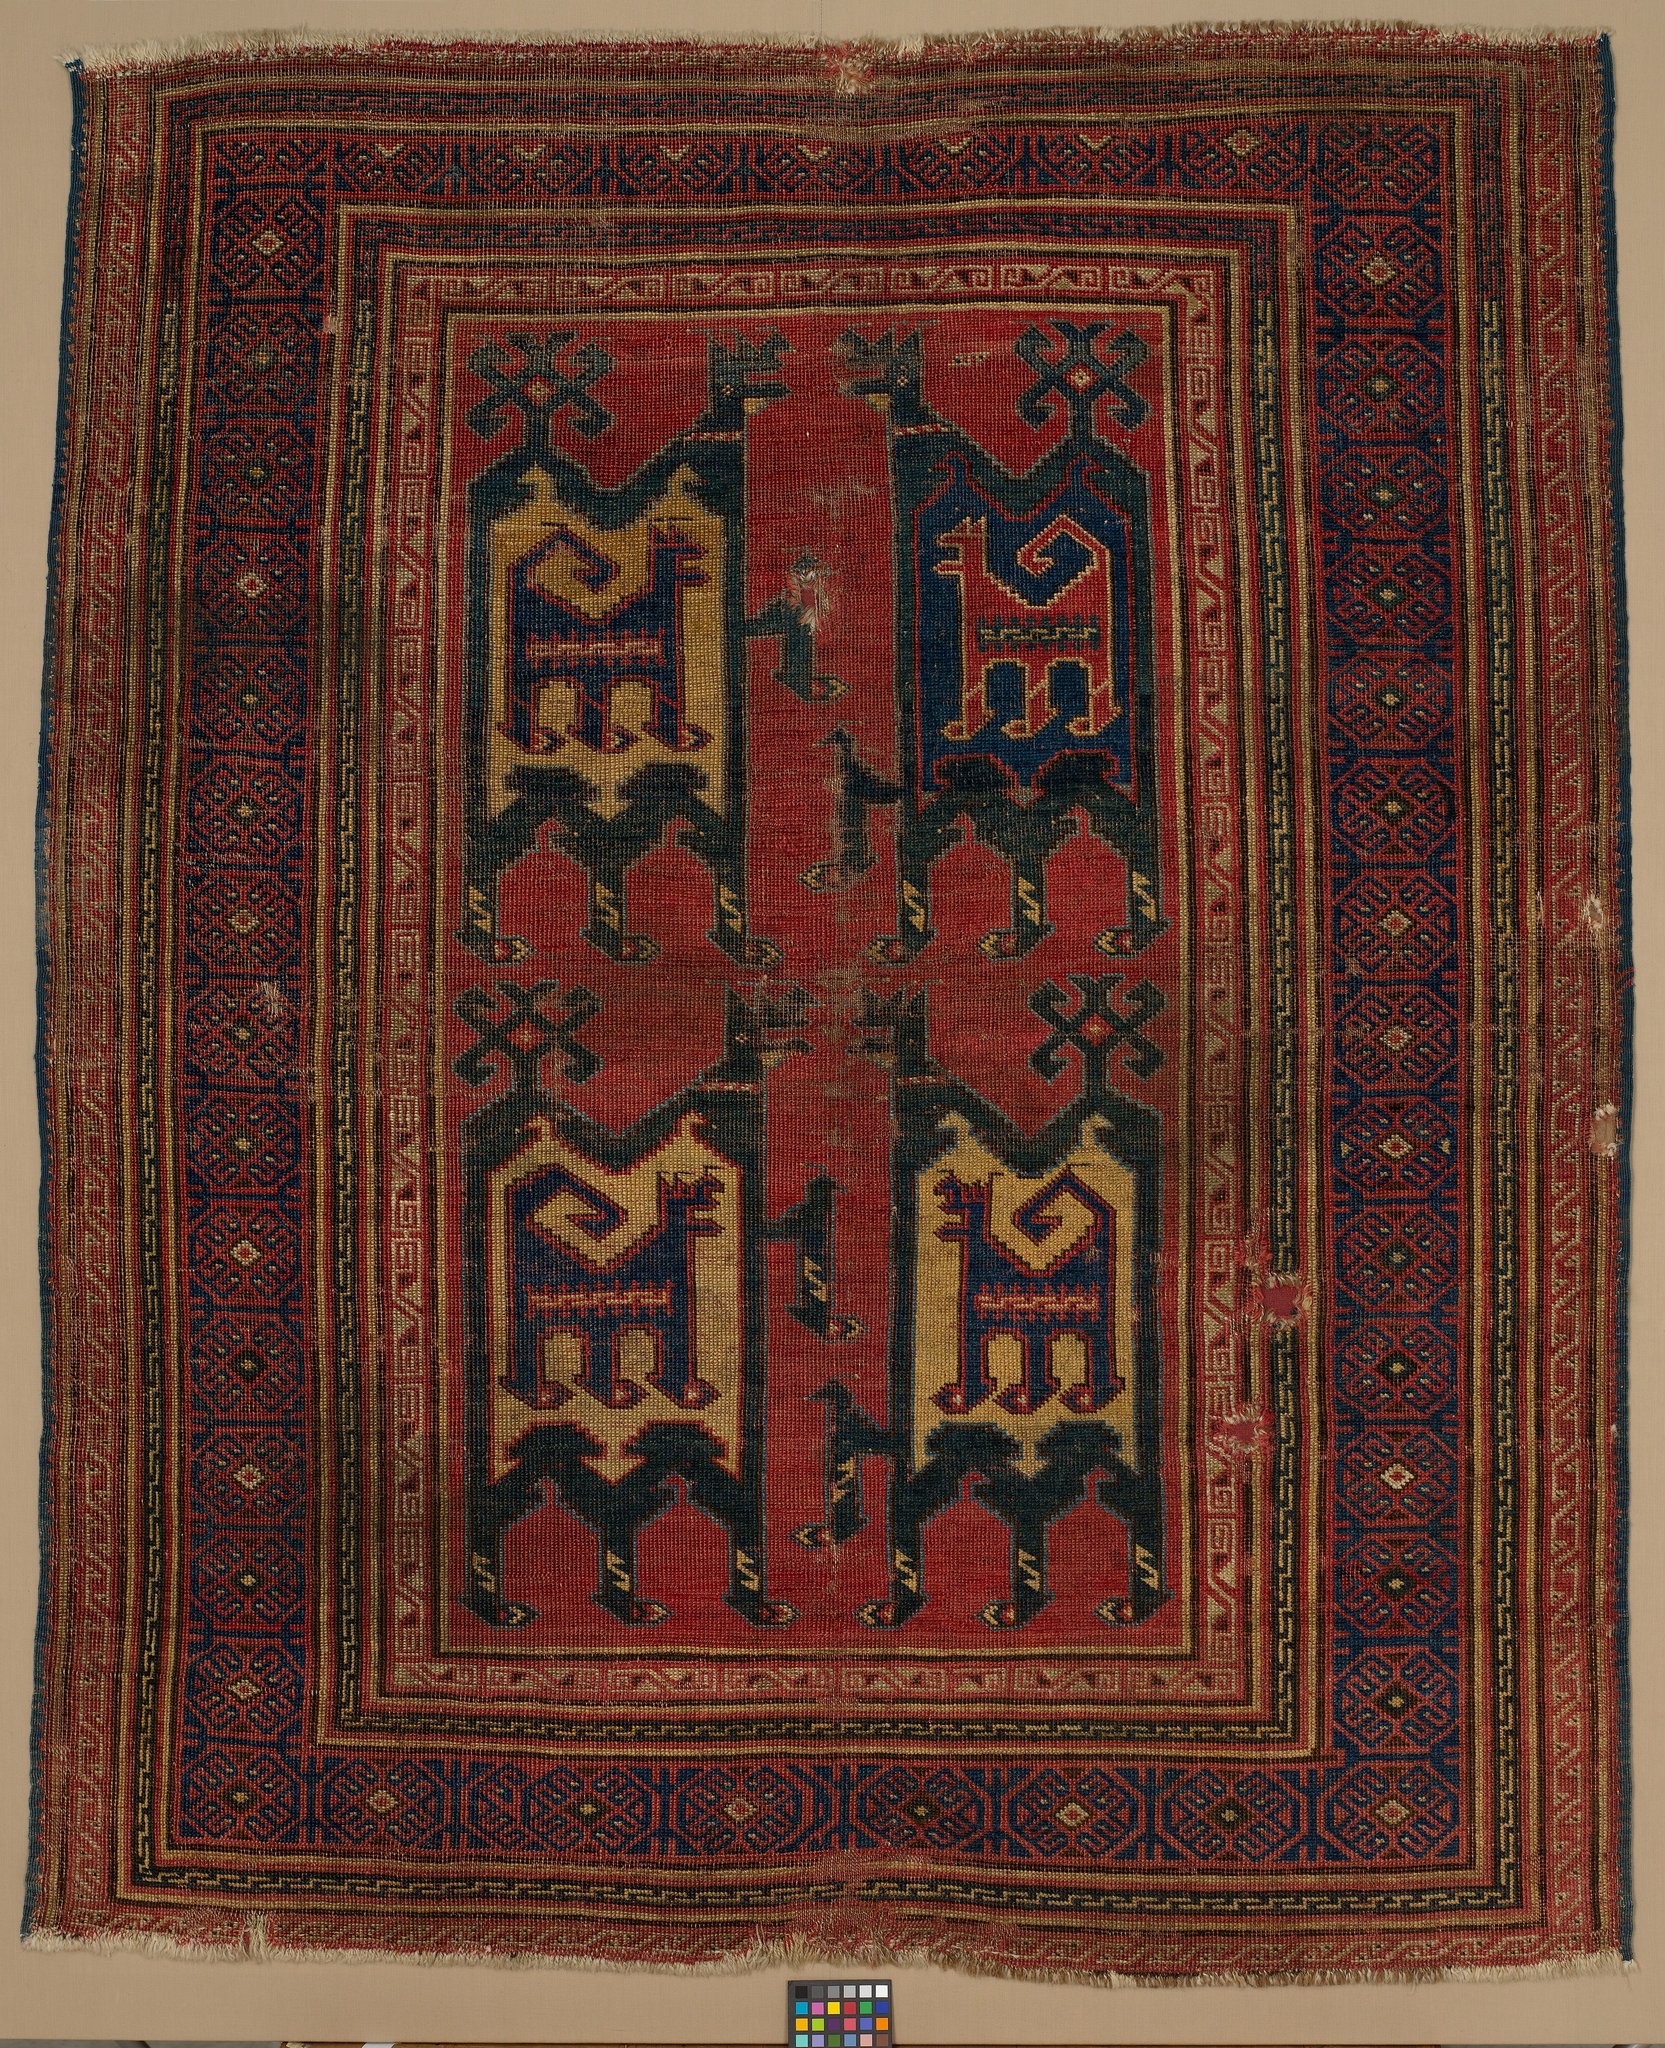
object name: carpet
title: Confronted Animal Rug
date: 1301-1400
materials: wool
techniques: pile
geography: turkey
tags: animals